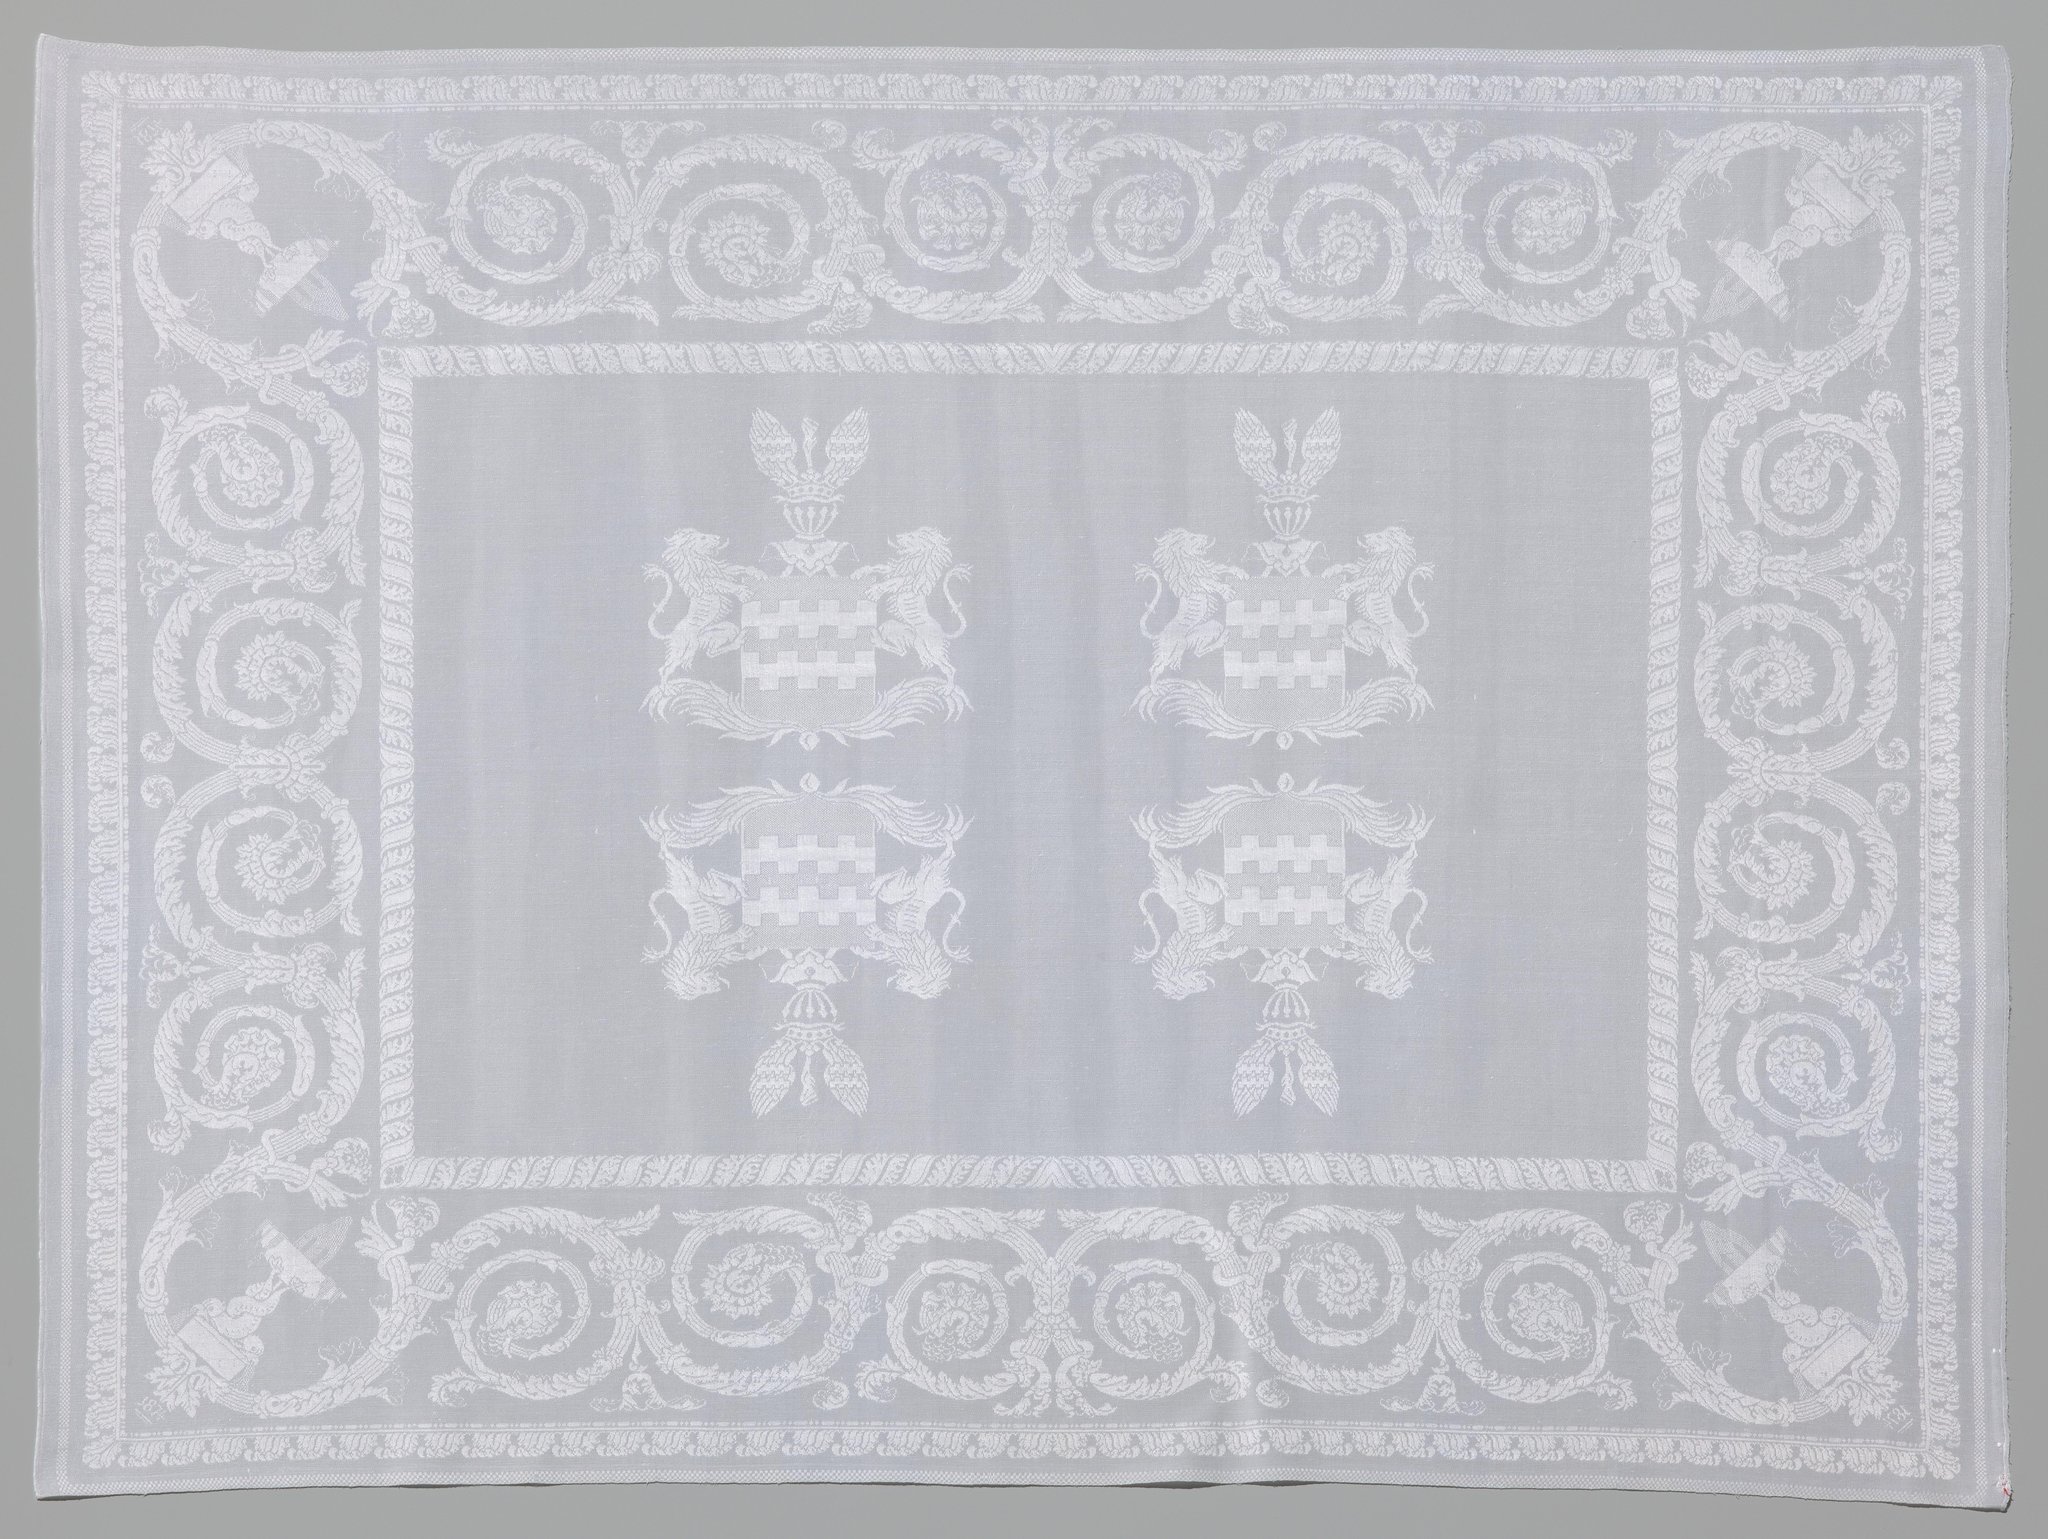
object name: napkin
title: Servet van wit linnendamast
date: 1874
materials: linen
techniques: damask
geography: north brabant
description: Wit linnen damasten servet met voluten en het wapen Van Boelens van der Haer.